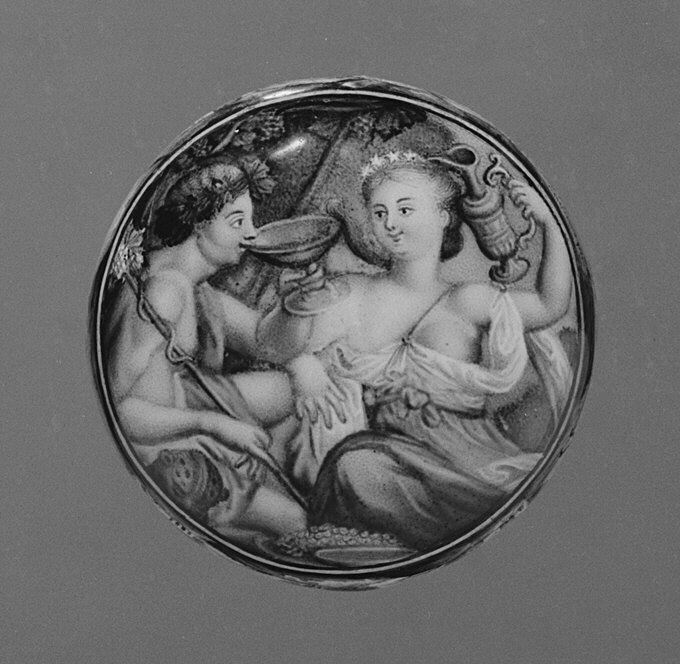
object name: box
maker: jean or pierre mussard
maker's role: artist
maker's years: 1707-1768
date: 1750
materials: copper, enamel, silver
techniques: painting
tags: men,women,drinking